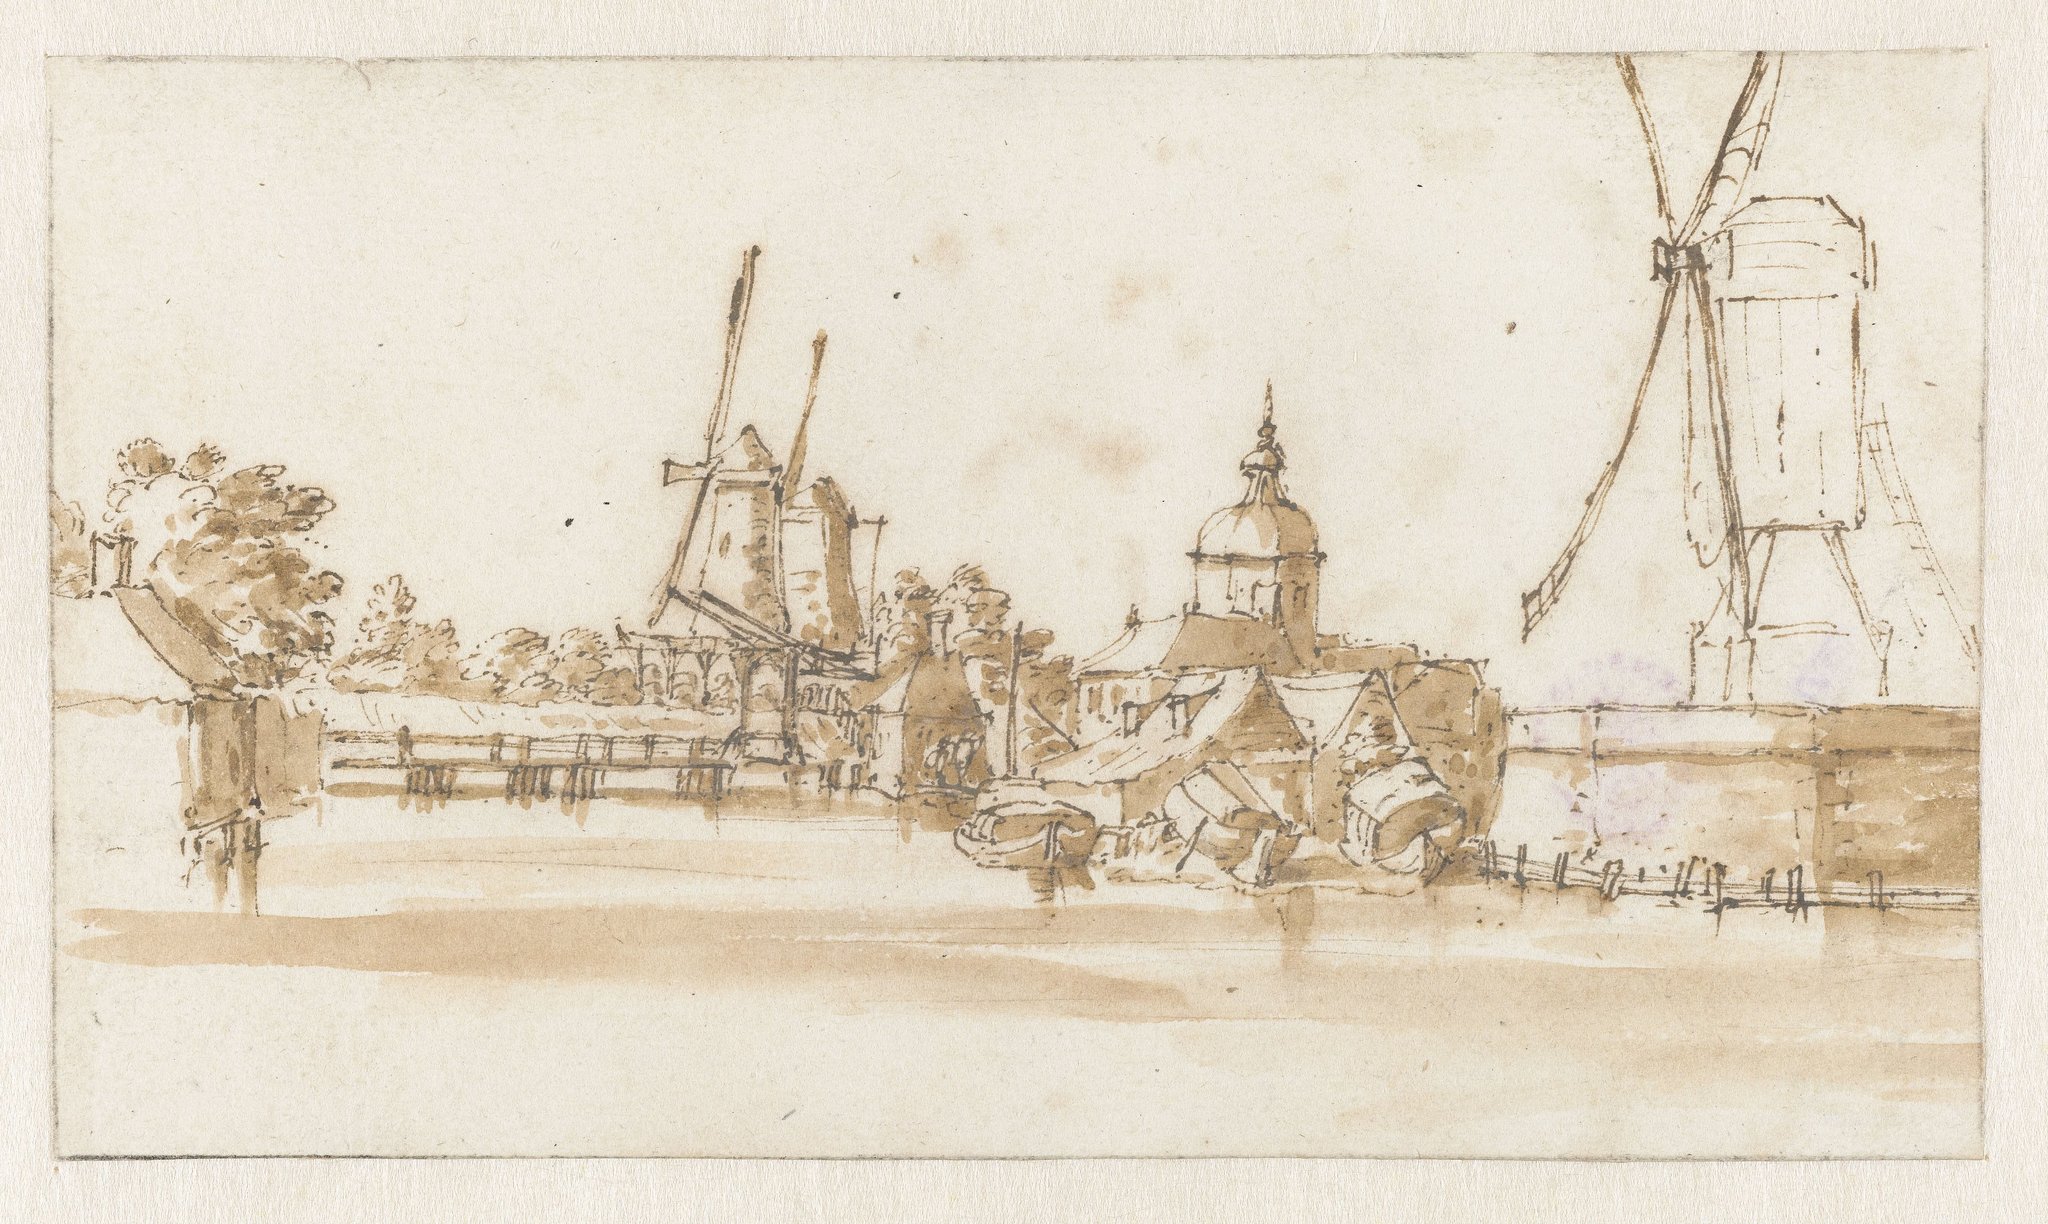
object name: drawing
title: Molens op de wal aan weerszijden van de Morspoort te Leiden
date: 1668-1697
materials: ink, paper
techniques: brush, pen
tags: city-walls, windmill, city-gate, canals, waters (in city) (+ city(-scape) with figures, staffage)